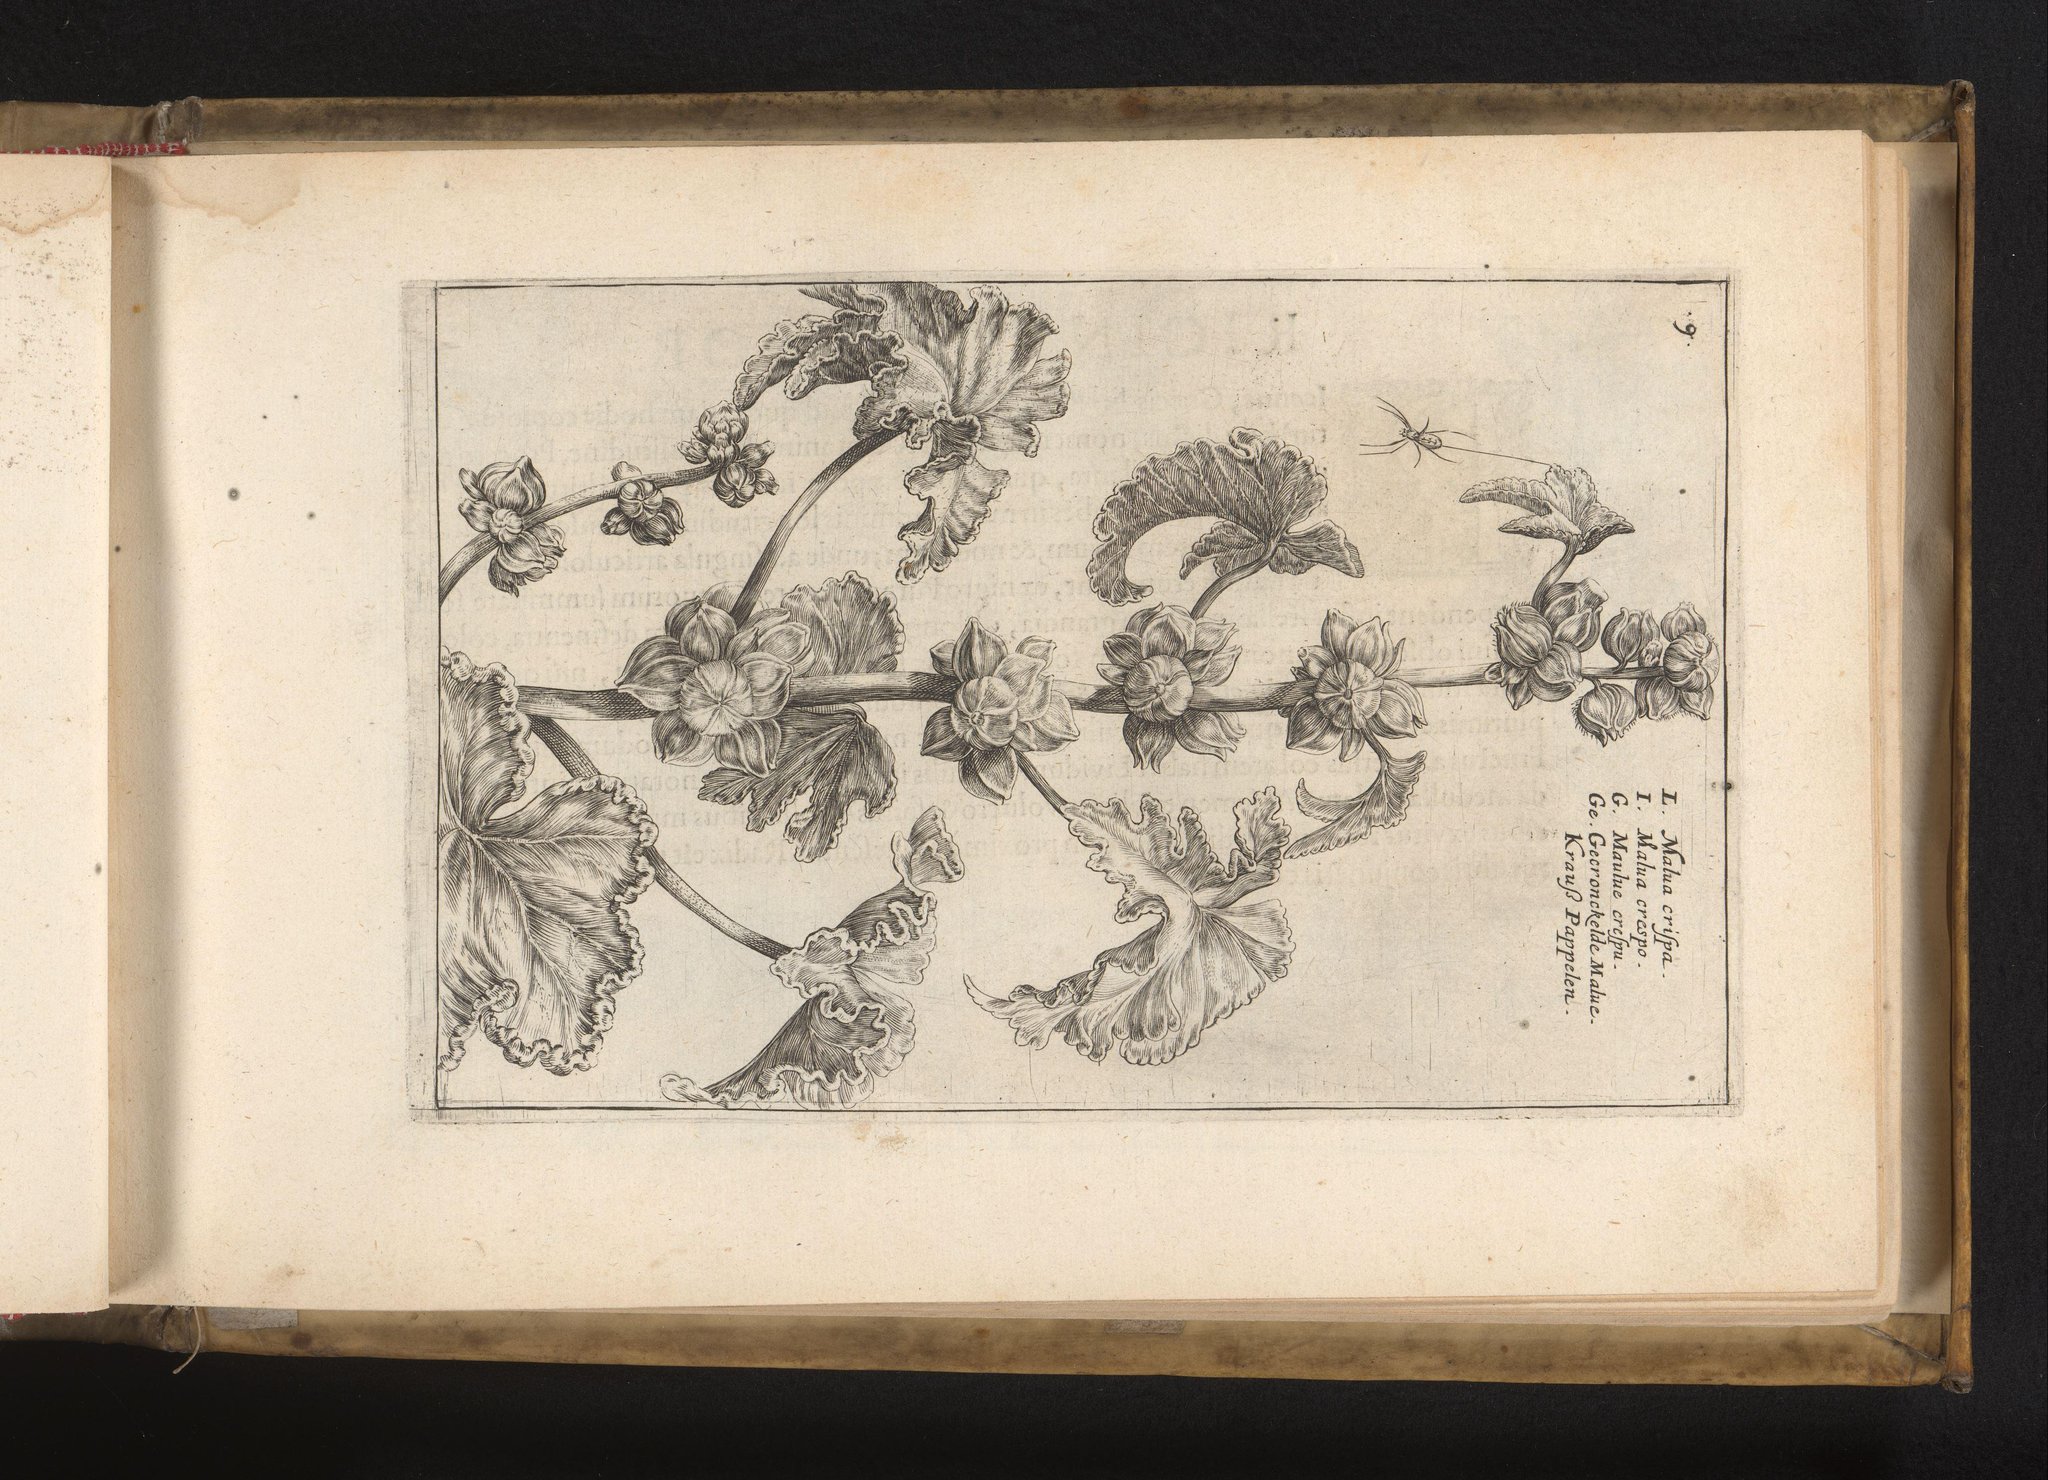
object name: print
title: Krulmalva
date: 1617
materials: paper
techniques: engraving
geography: utrecht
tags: flowers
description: Prent uit: Passe, Crispijn van de (II). Hortus floridus in quo rariorum & minus vulgarium florum icones ad vivam veramque formam. Arnhem: Johannes Janssonius, 1617.